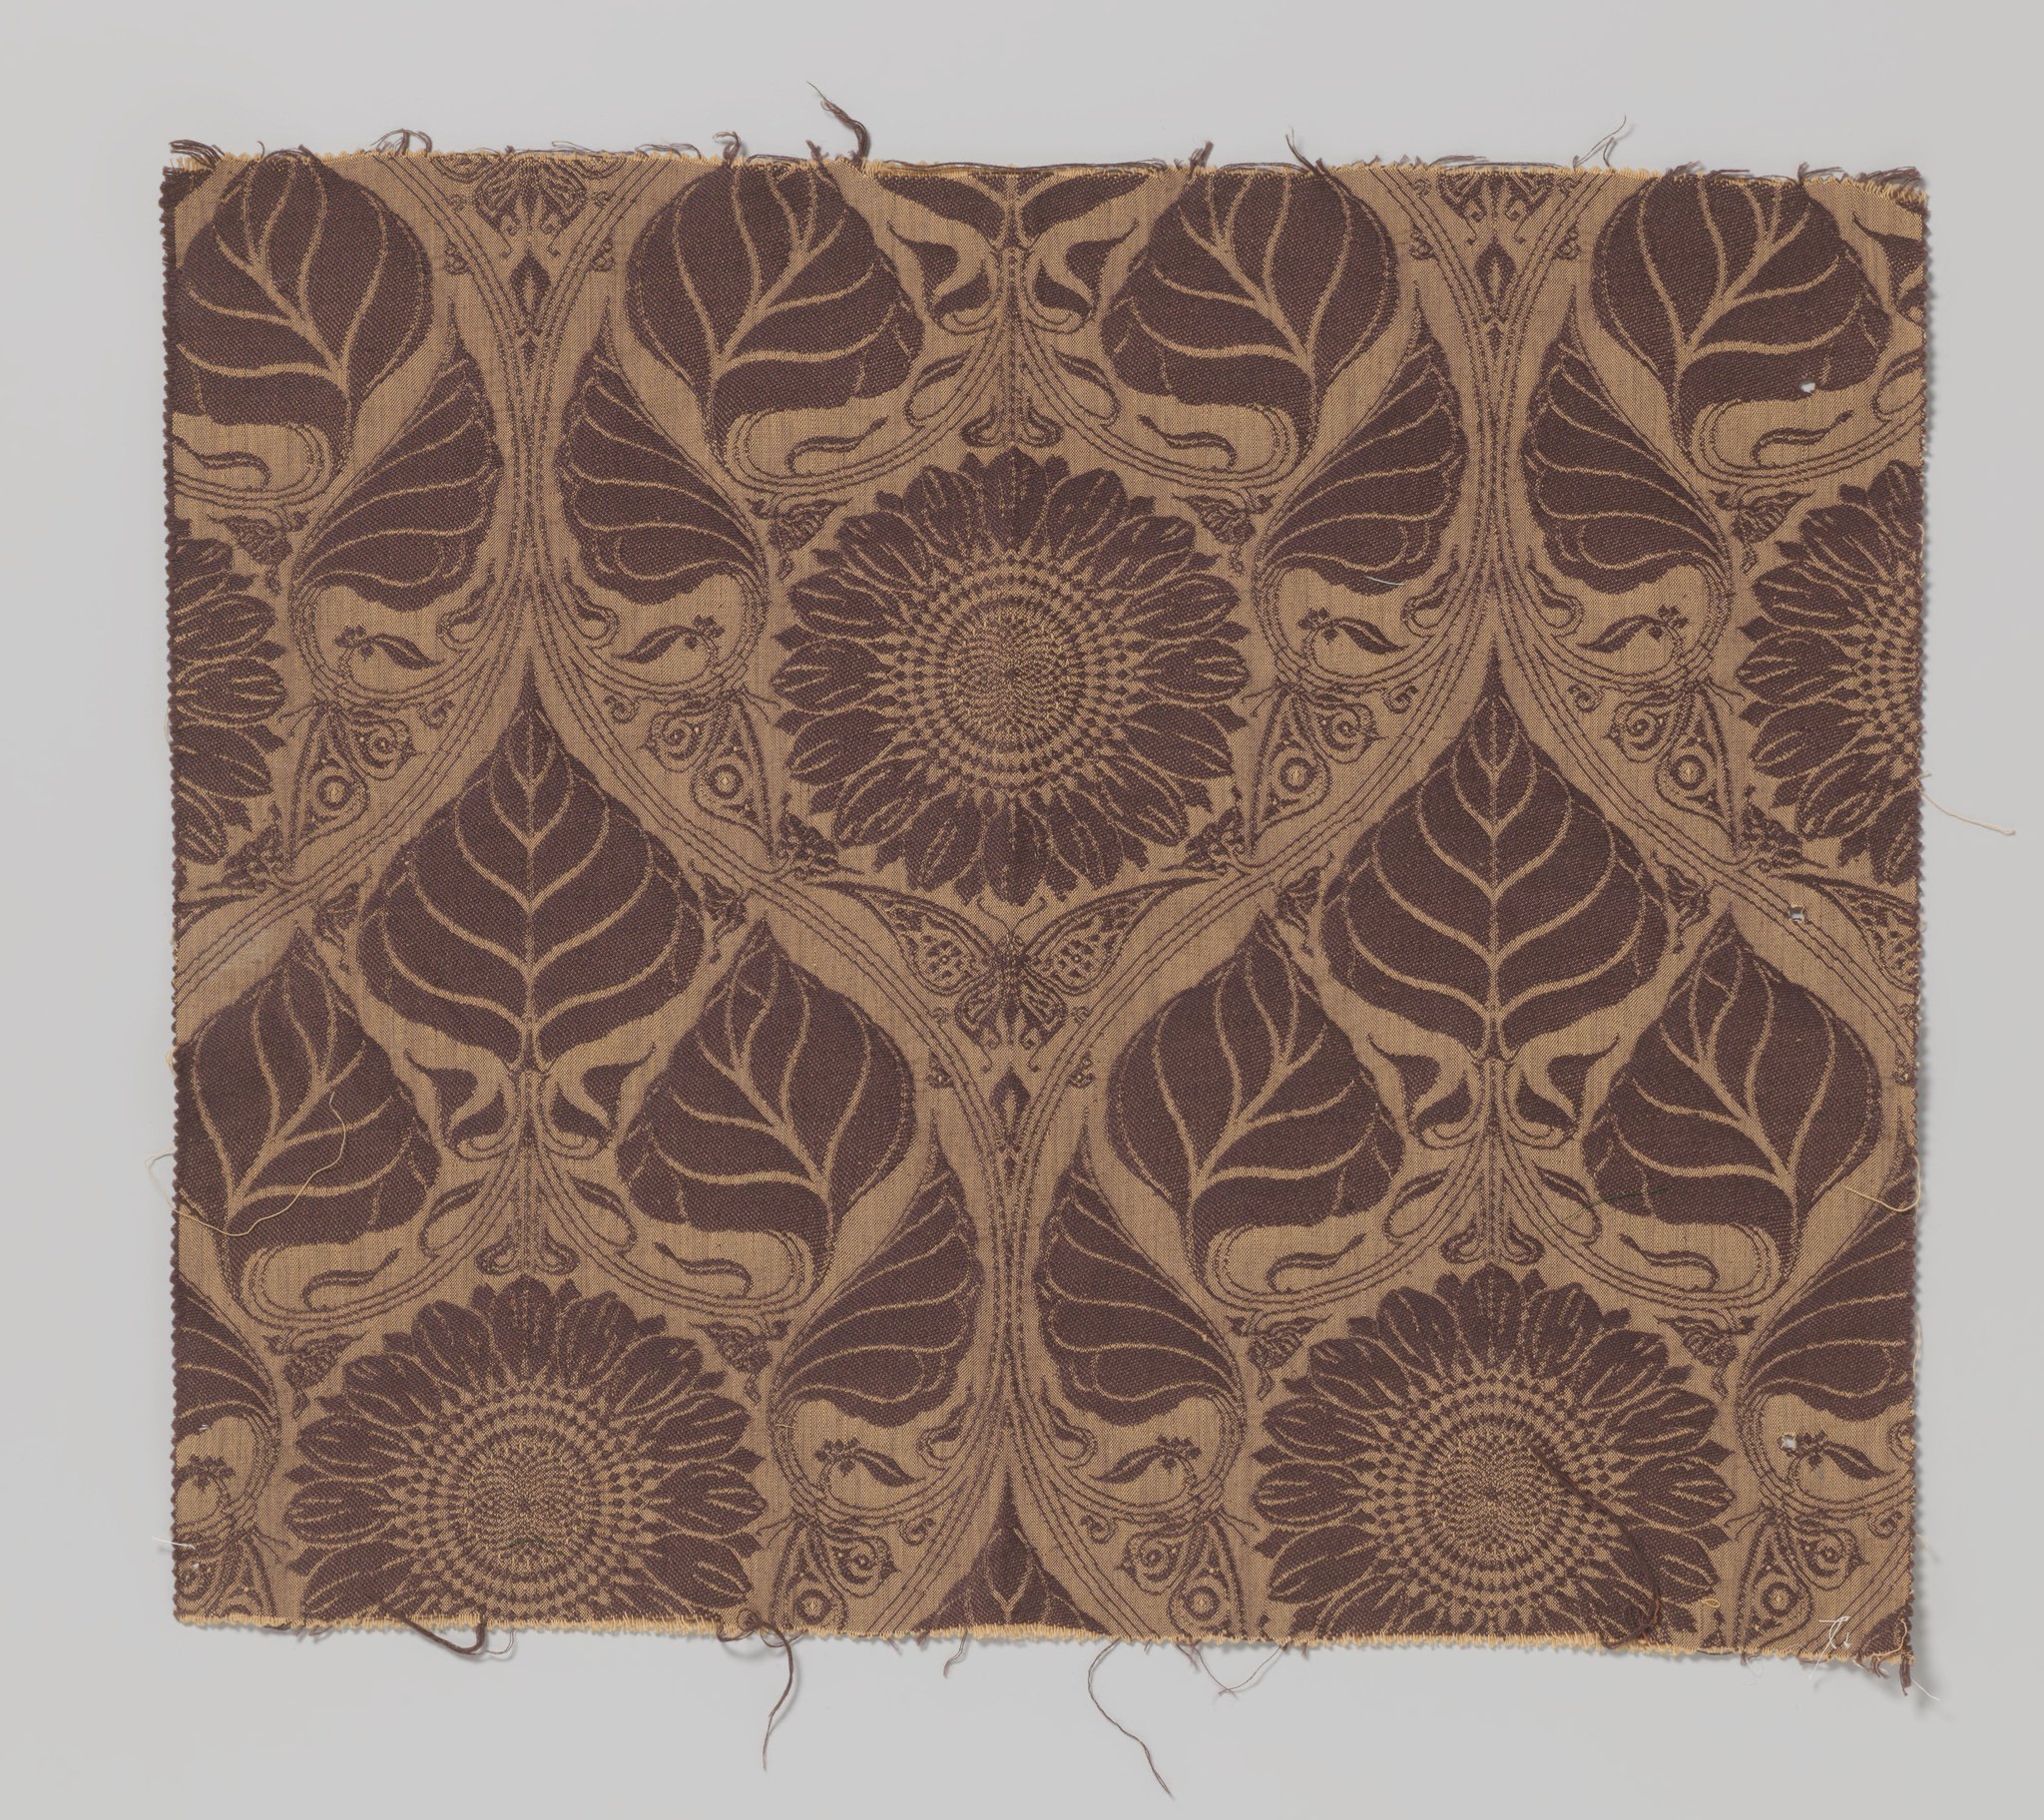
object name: upholstery fabric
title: Fragment van bespanningsstof met patroon van zonnebloem en vlinders binnen spitsovalen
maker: theo nieuwenhuis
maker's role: designer, draughtsman, print maker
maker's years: 1866-1951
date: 1909-1924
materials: cotton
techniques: jacquard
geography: helmond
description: Fragment van bespanningsstof met patroon van zonnebloem en vlinders binnen spitsovalen. Paarse inslag op geel-witte ketting.